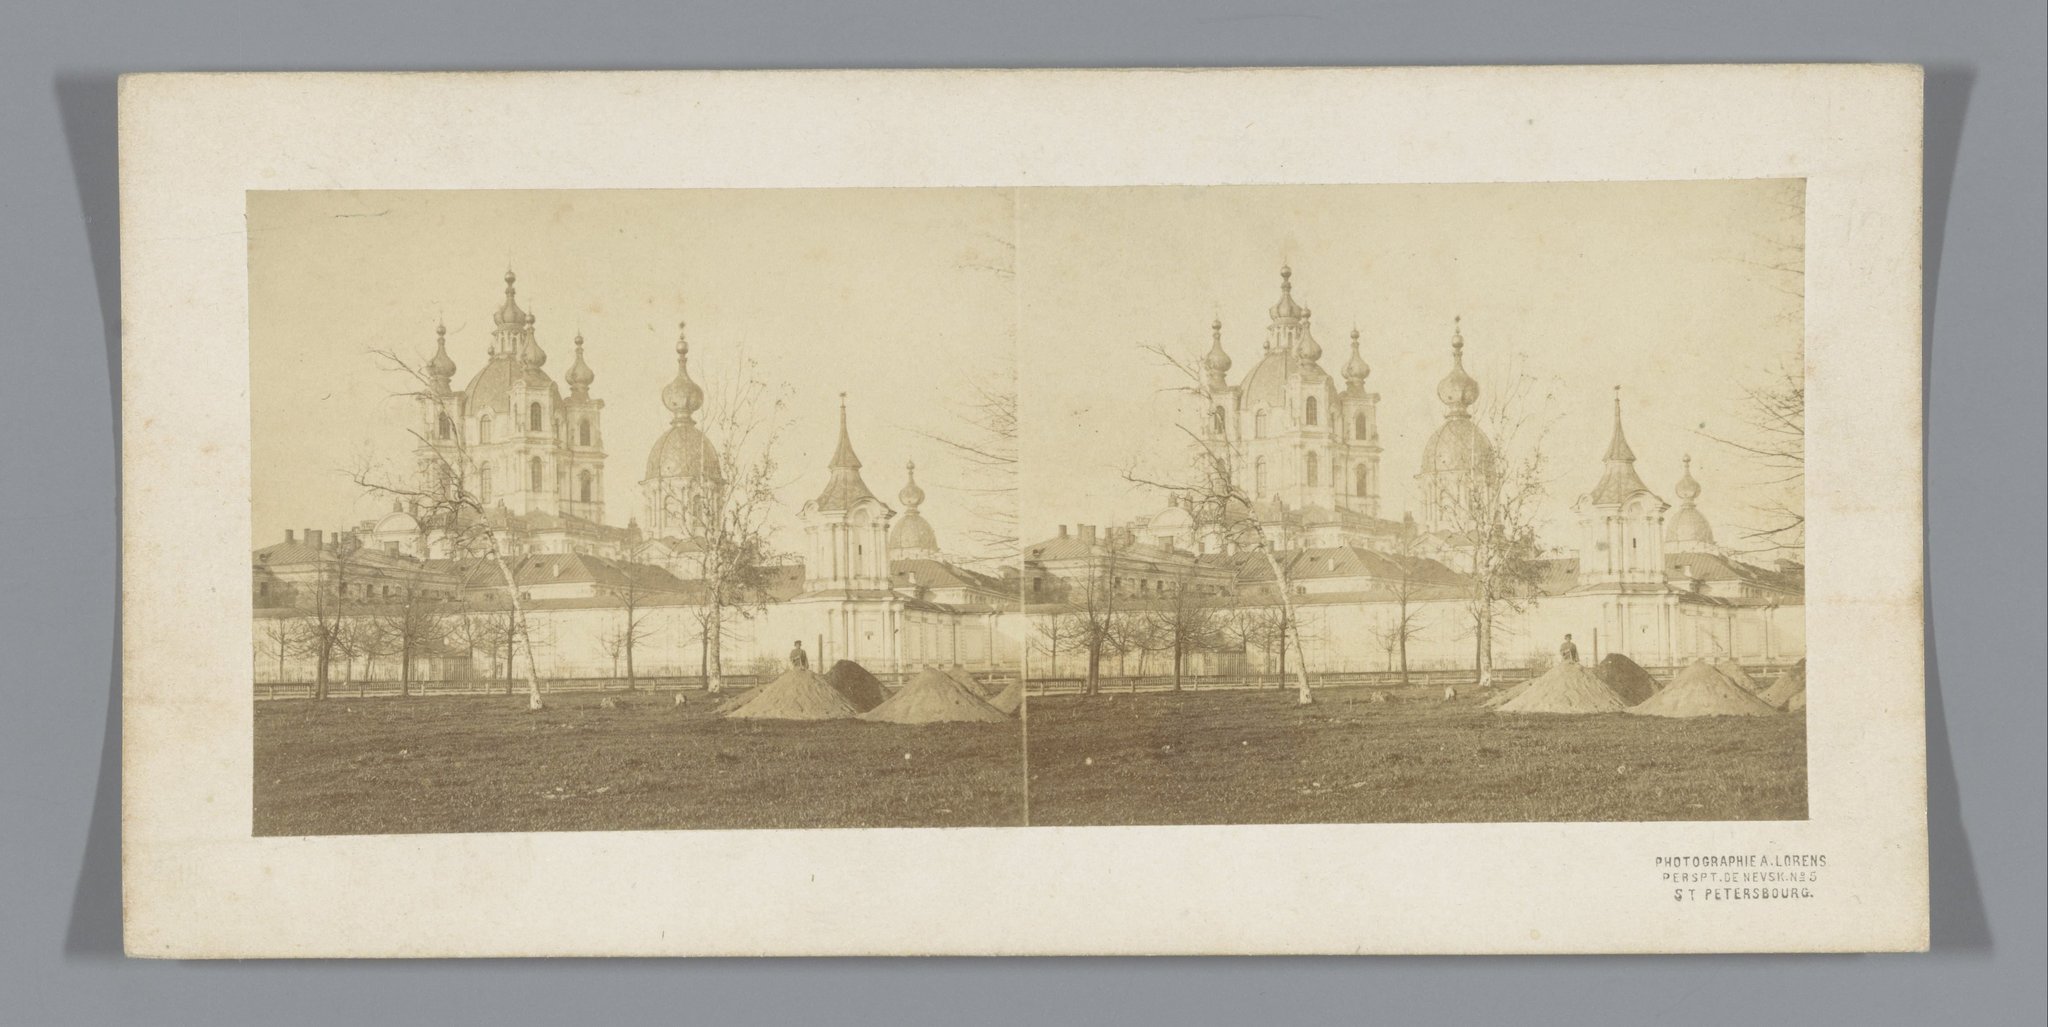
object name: stereograph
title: Gezicht op het Alexander Nevski-klooster in Sint-Petersburg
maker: alfred lorens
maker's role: fotograaf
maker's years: 1830-1896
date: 1860-1880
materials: cardboard, photographic support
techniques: albumen print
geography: sint-petersburg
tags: tower, clock tower ~ monumental adornment, cloisters ~ monastery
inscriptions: inscription: ‘St. Petersburg, [...] Nevsky-Perspectief, met Nevsky-klooster’, number: ‘6. 3.’, name: ‘PHOTOGRAPHIE A.LORENS PERSPT.DE NEVSK. NO 5 ST PETERSBOURG.’